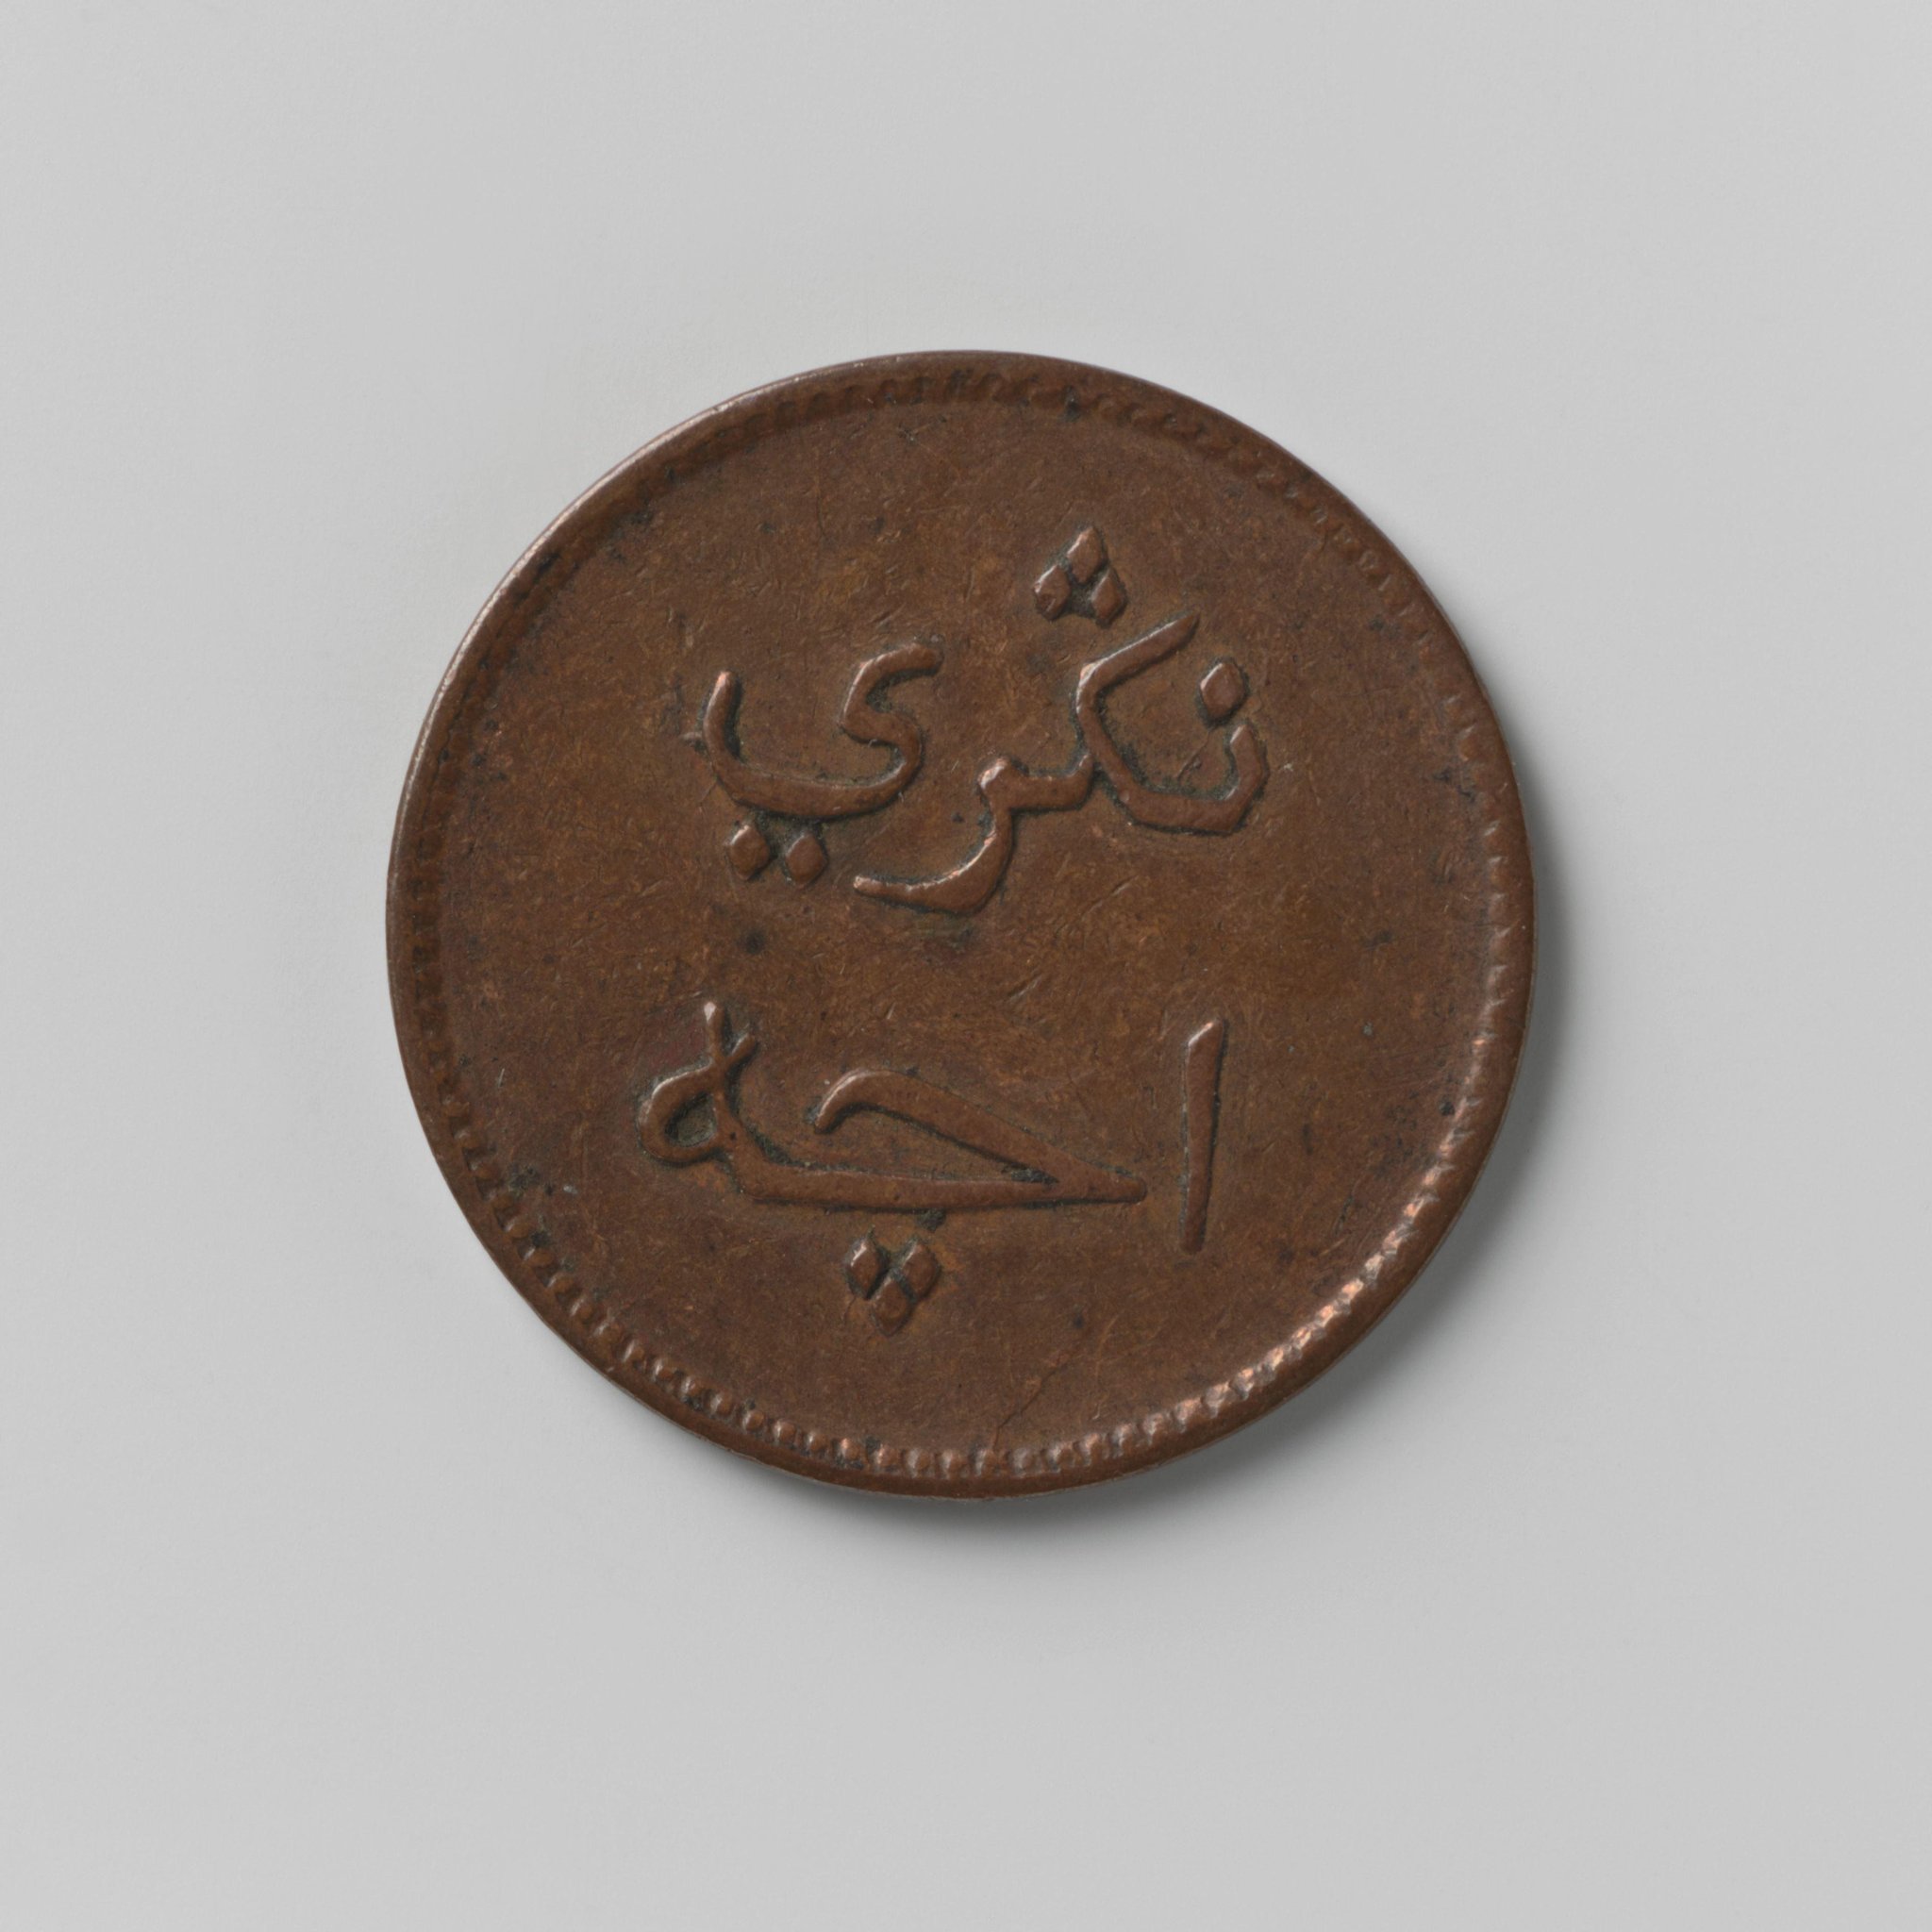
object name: coin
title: 2 kepengs voor Atjeh op Sumatra, 1831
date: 1831-1832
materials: copper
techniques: striking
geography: birmingham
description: Koperen munt. Particuliere munt. Voorzijde: tweeregelig opschrift: aanduiding in het Maleis in Arabische lettertekens: Negri Atjeh, waarboven en waaronder zon. Keerzijde: eenregelig Maleis opschrift in Arabische lettertekens: twee kepeng, waarboven waarde-aanduiding 2 en waaronder het jaartal 1247 in Islamitische tijdsrekening. Gladde rand.